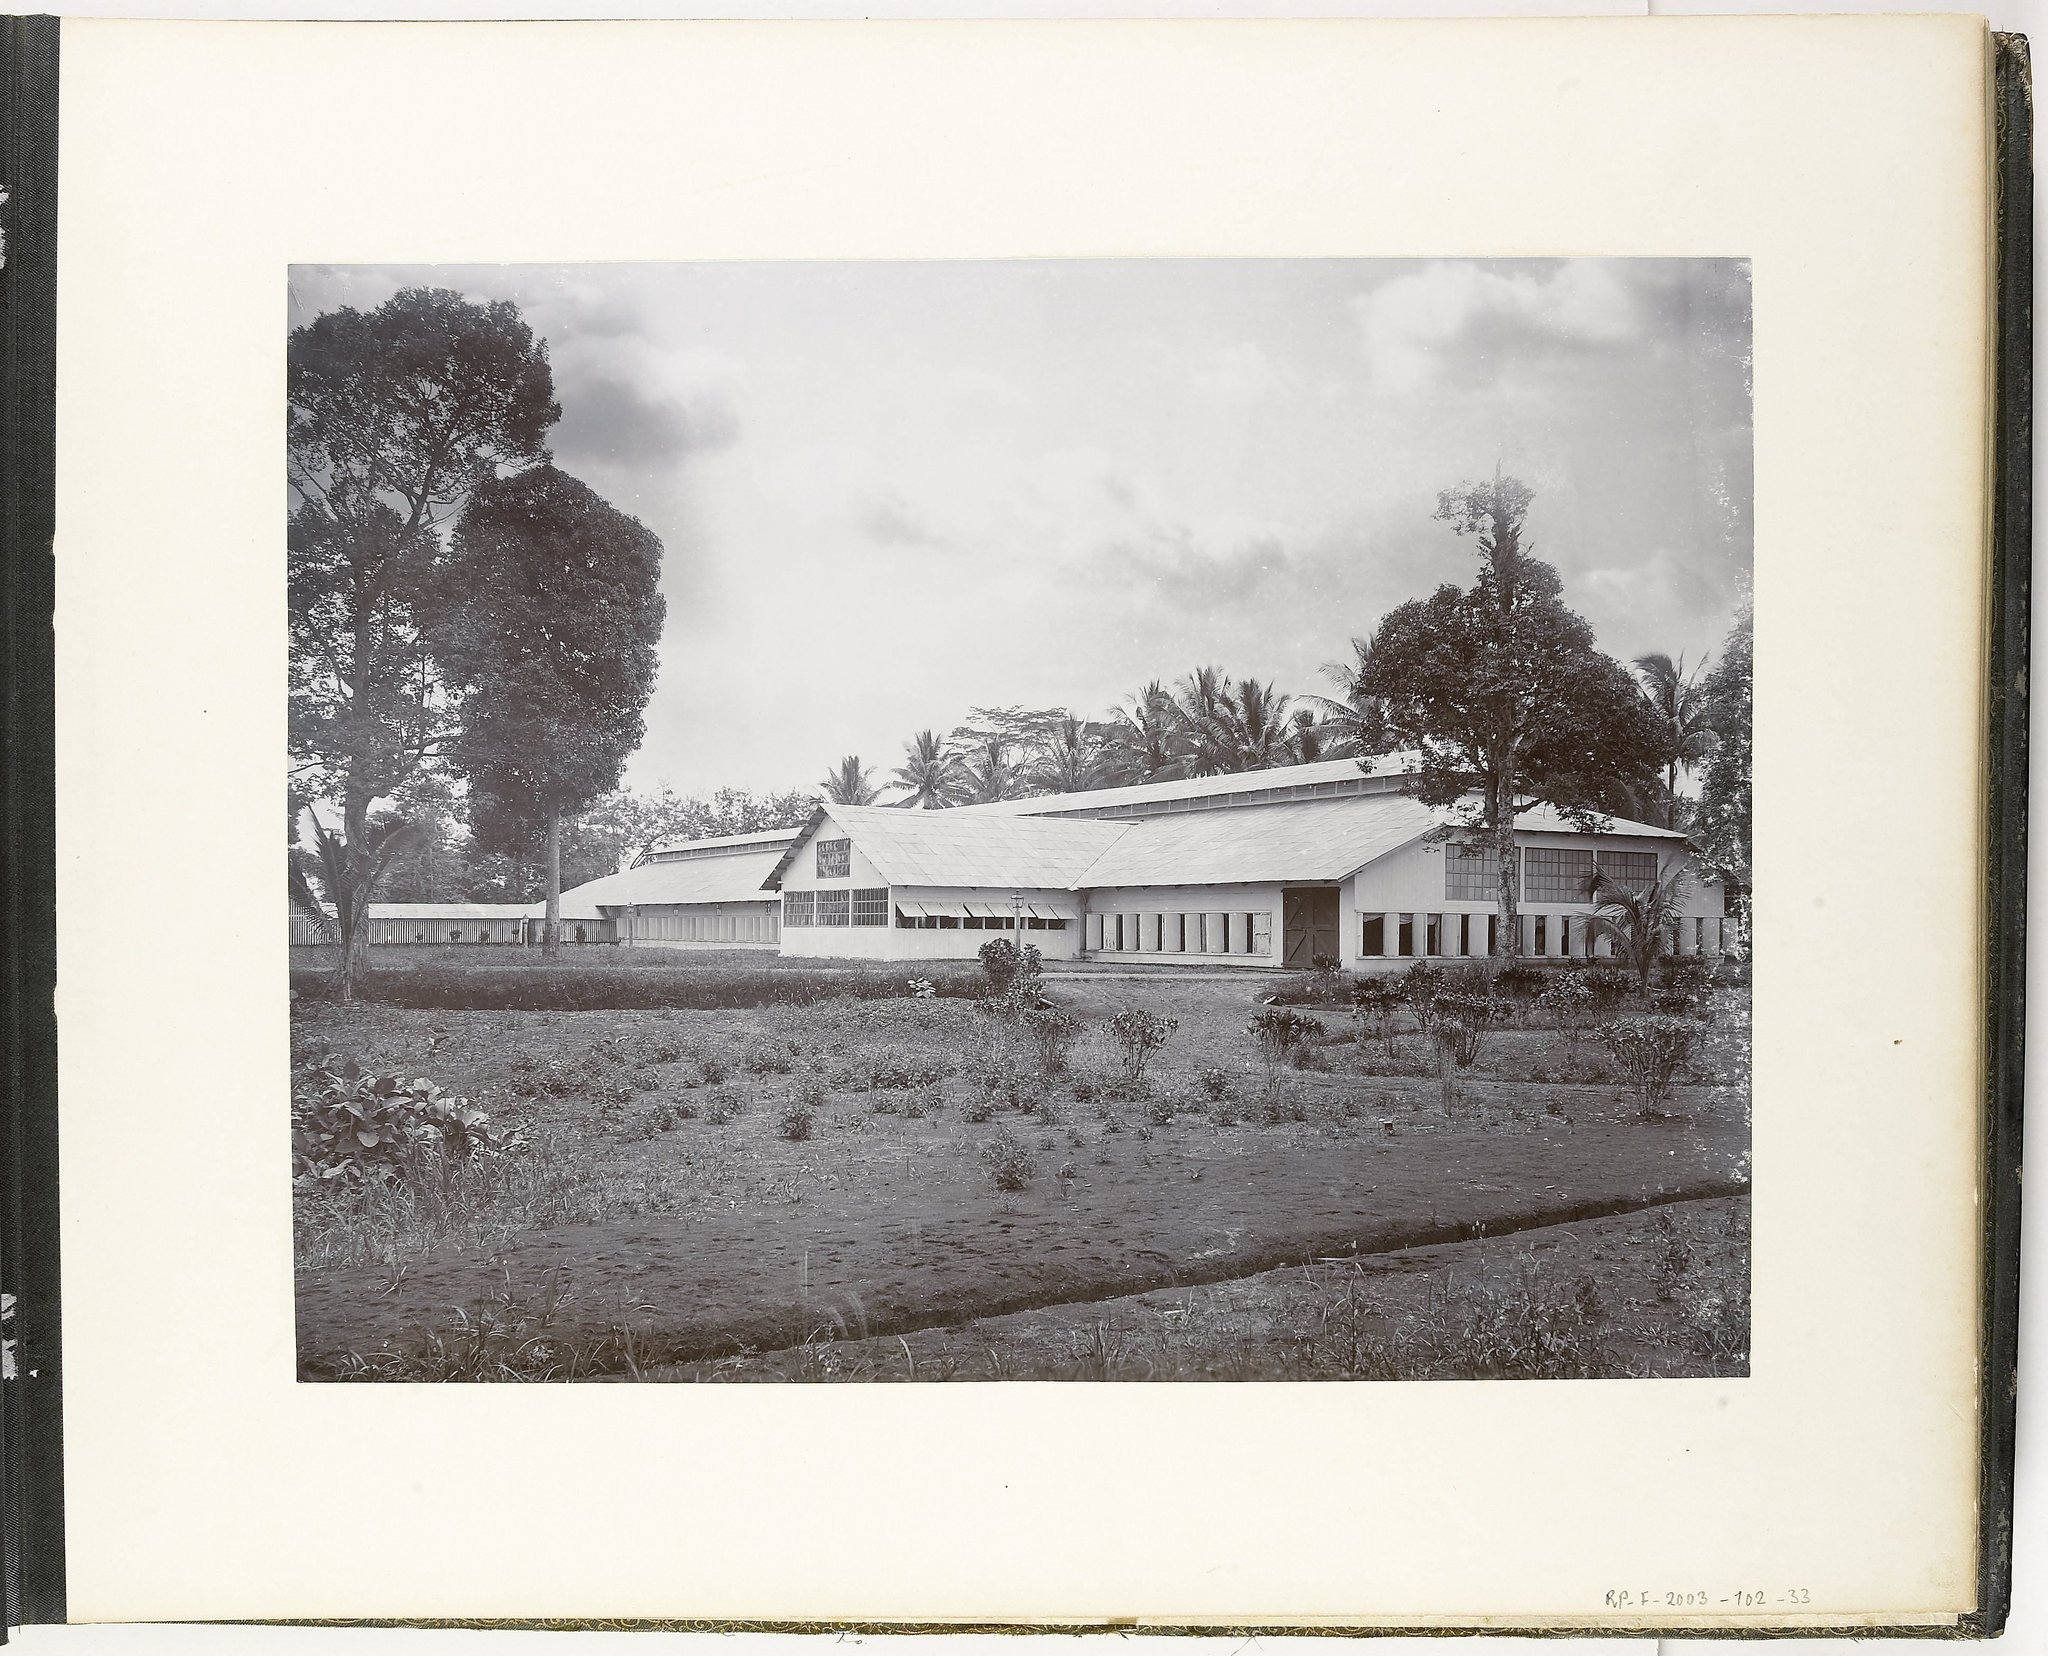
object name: photograph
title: Fermenteerschuur Aneta Mineh, Sumatra (Fermentierscheune Aneta Mineh)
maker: carl j. kleingrothe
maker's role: fotograaf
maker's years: 1864-1925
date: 1885-1900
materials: photographic support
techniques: collodion silver print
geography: sumatra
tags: sumatra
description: Gezicht op de fermenteerschuur Aneta Mineh op Sumatra. Onderdeel van het Sumatra fotoalbum van Paul en Lucie Sandel uit 1900.